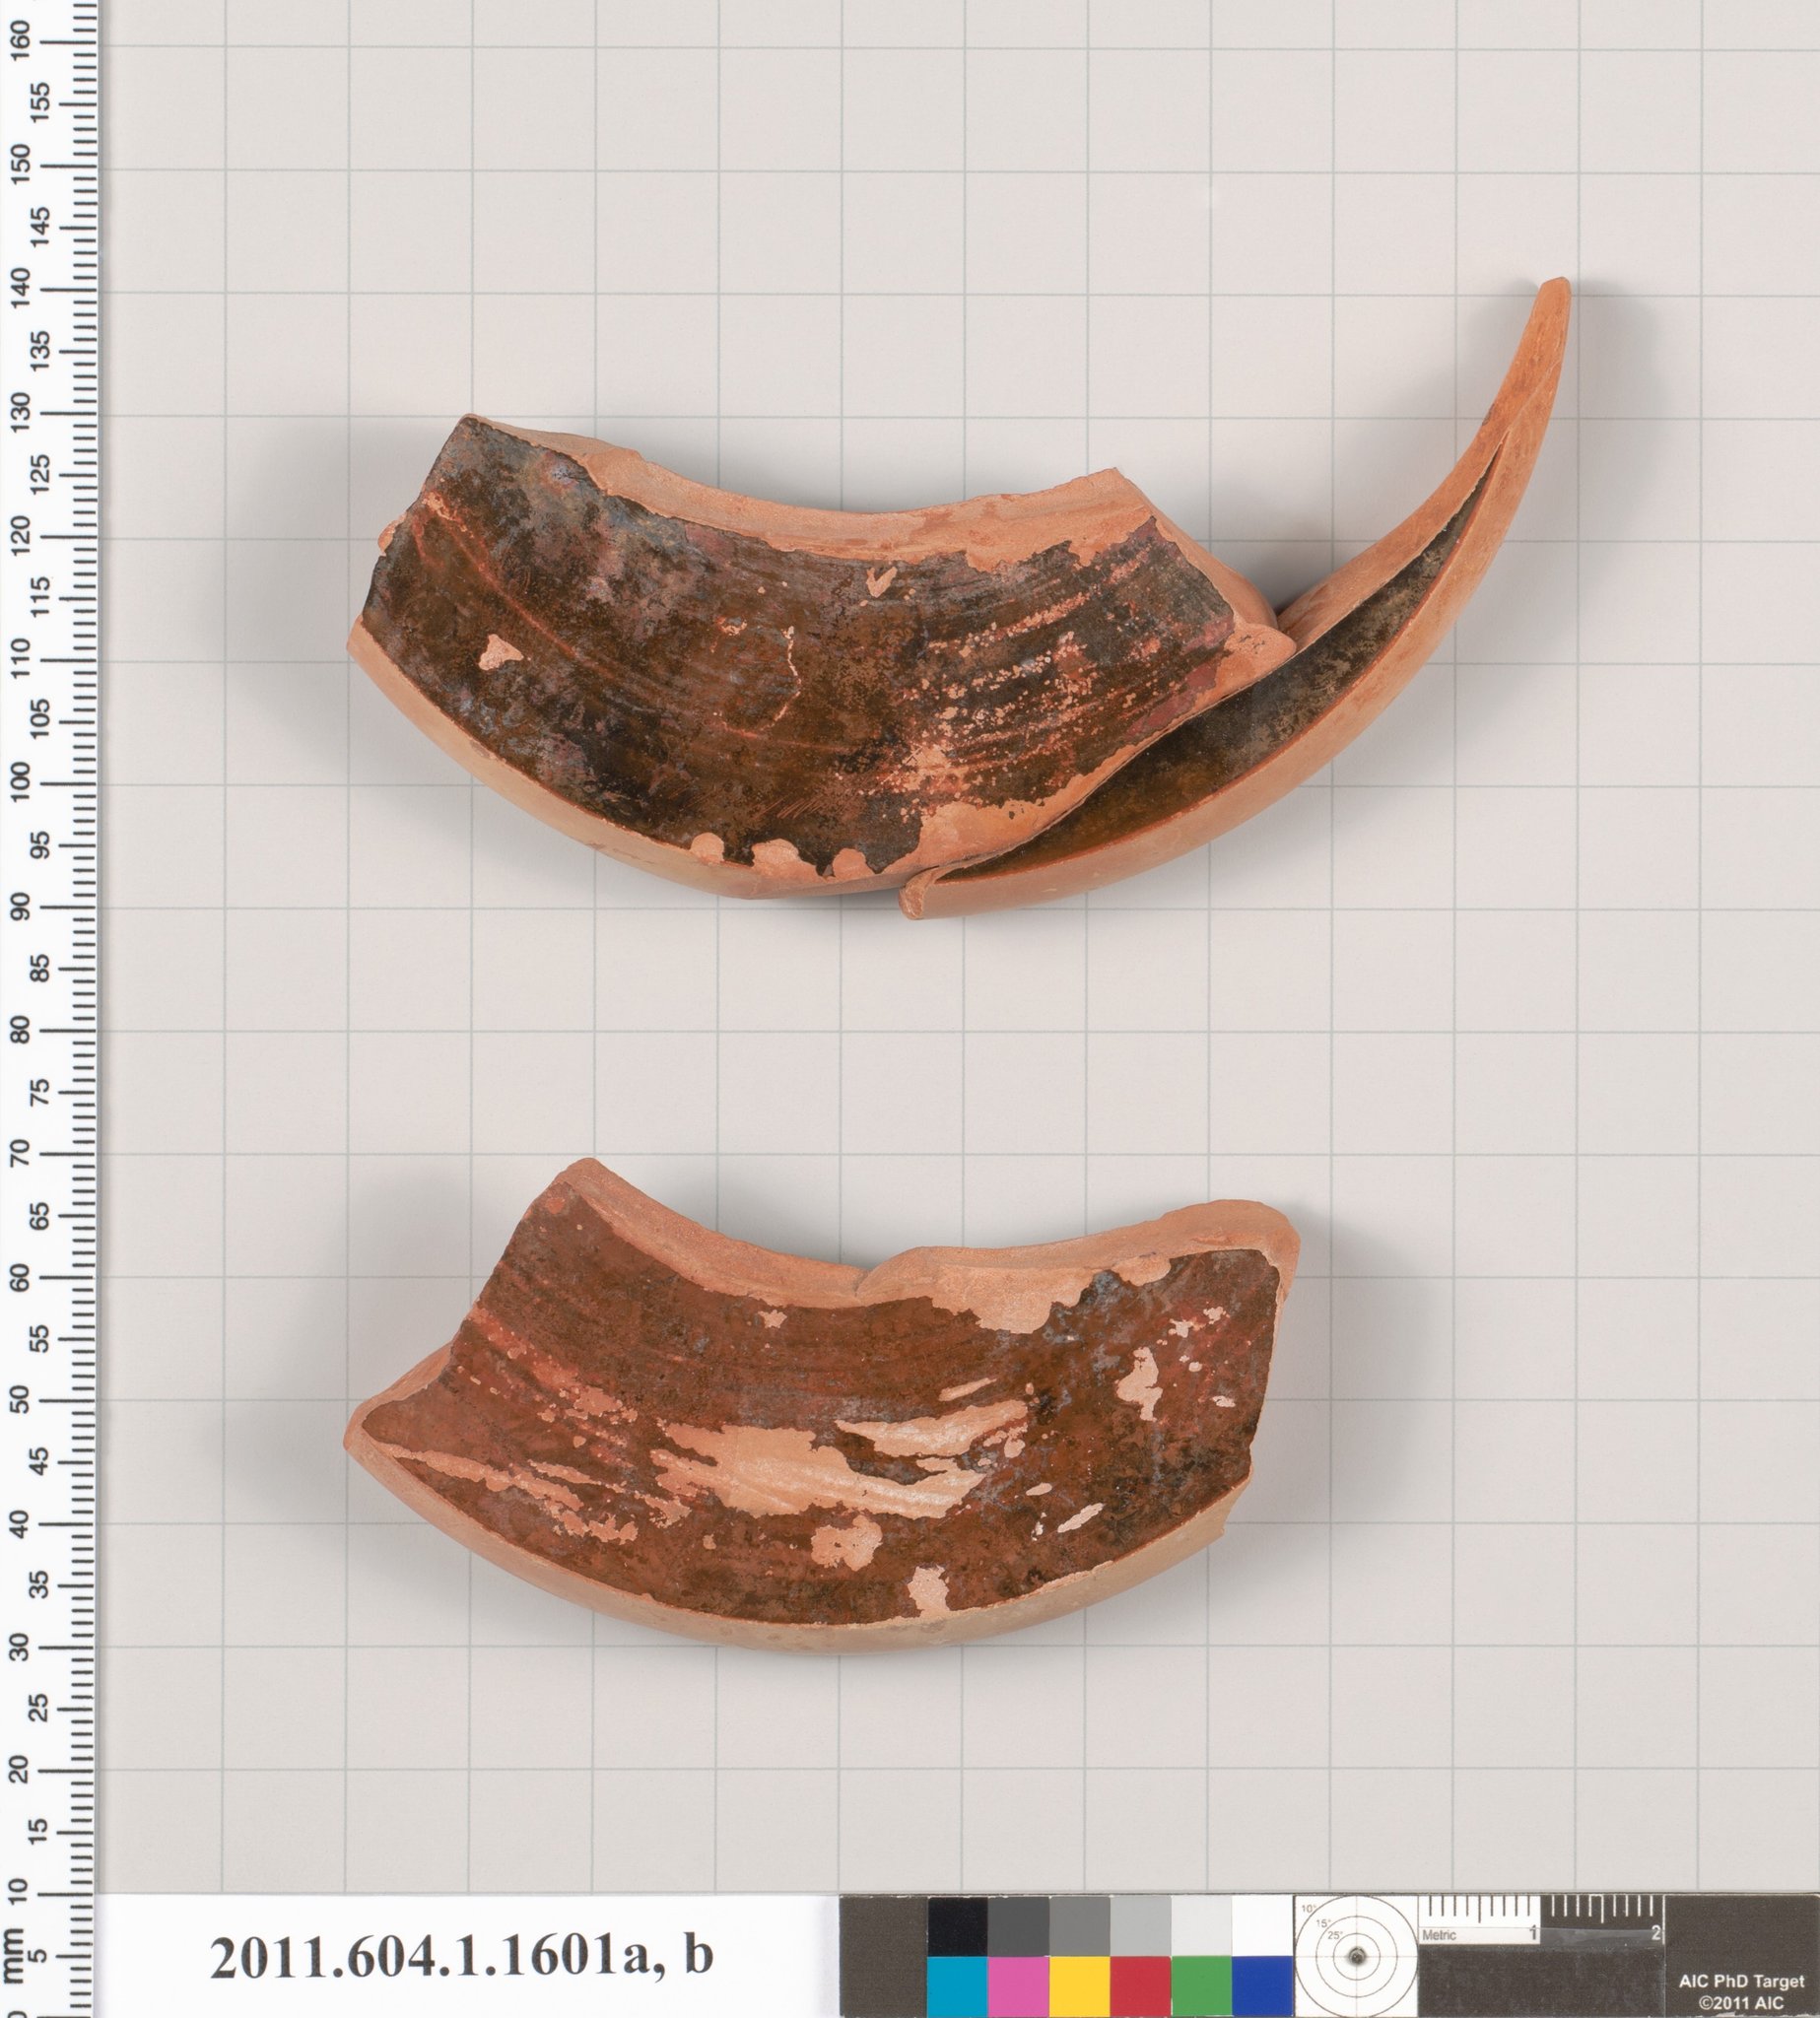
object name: kylix fragment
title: Terracotta fragments of kylikes (drinking cups)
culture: greek, attic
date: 500-401 BCE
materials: terracotta